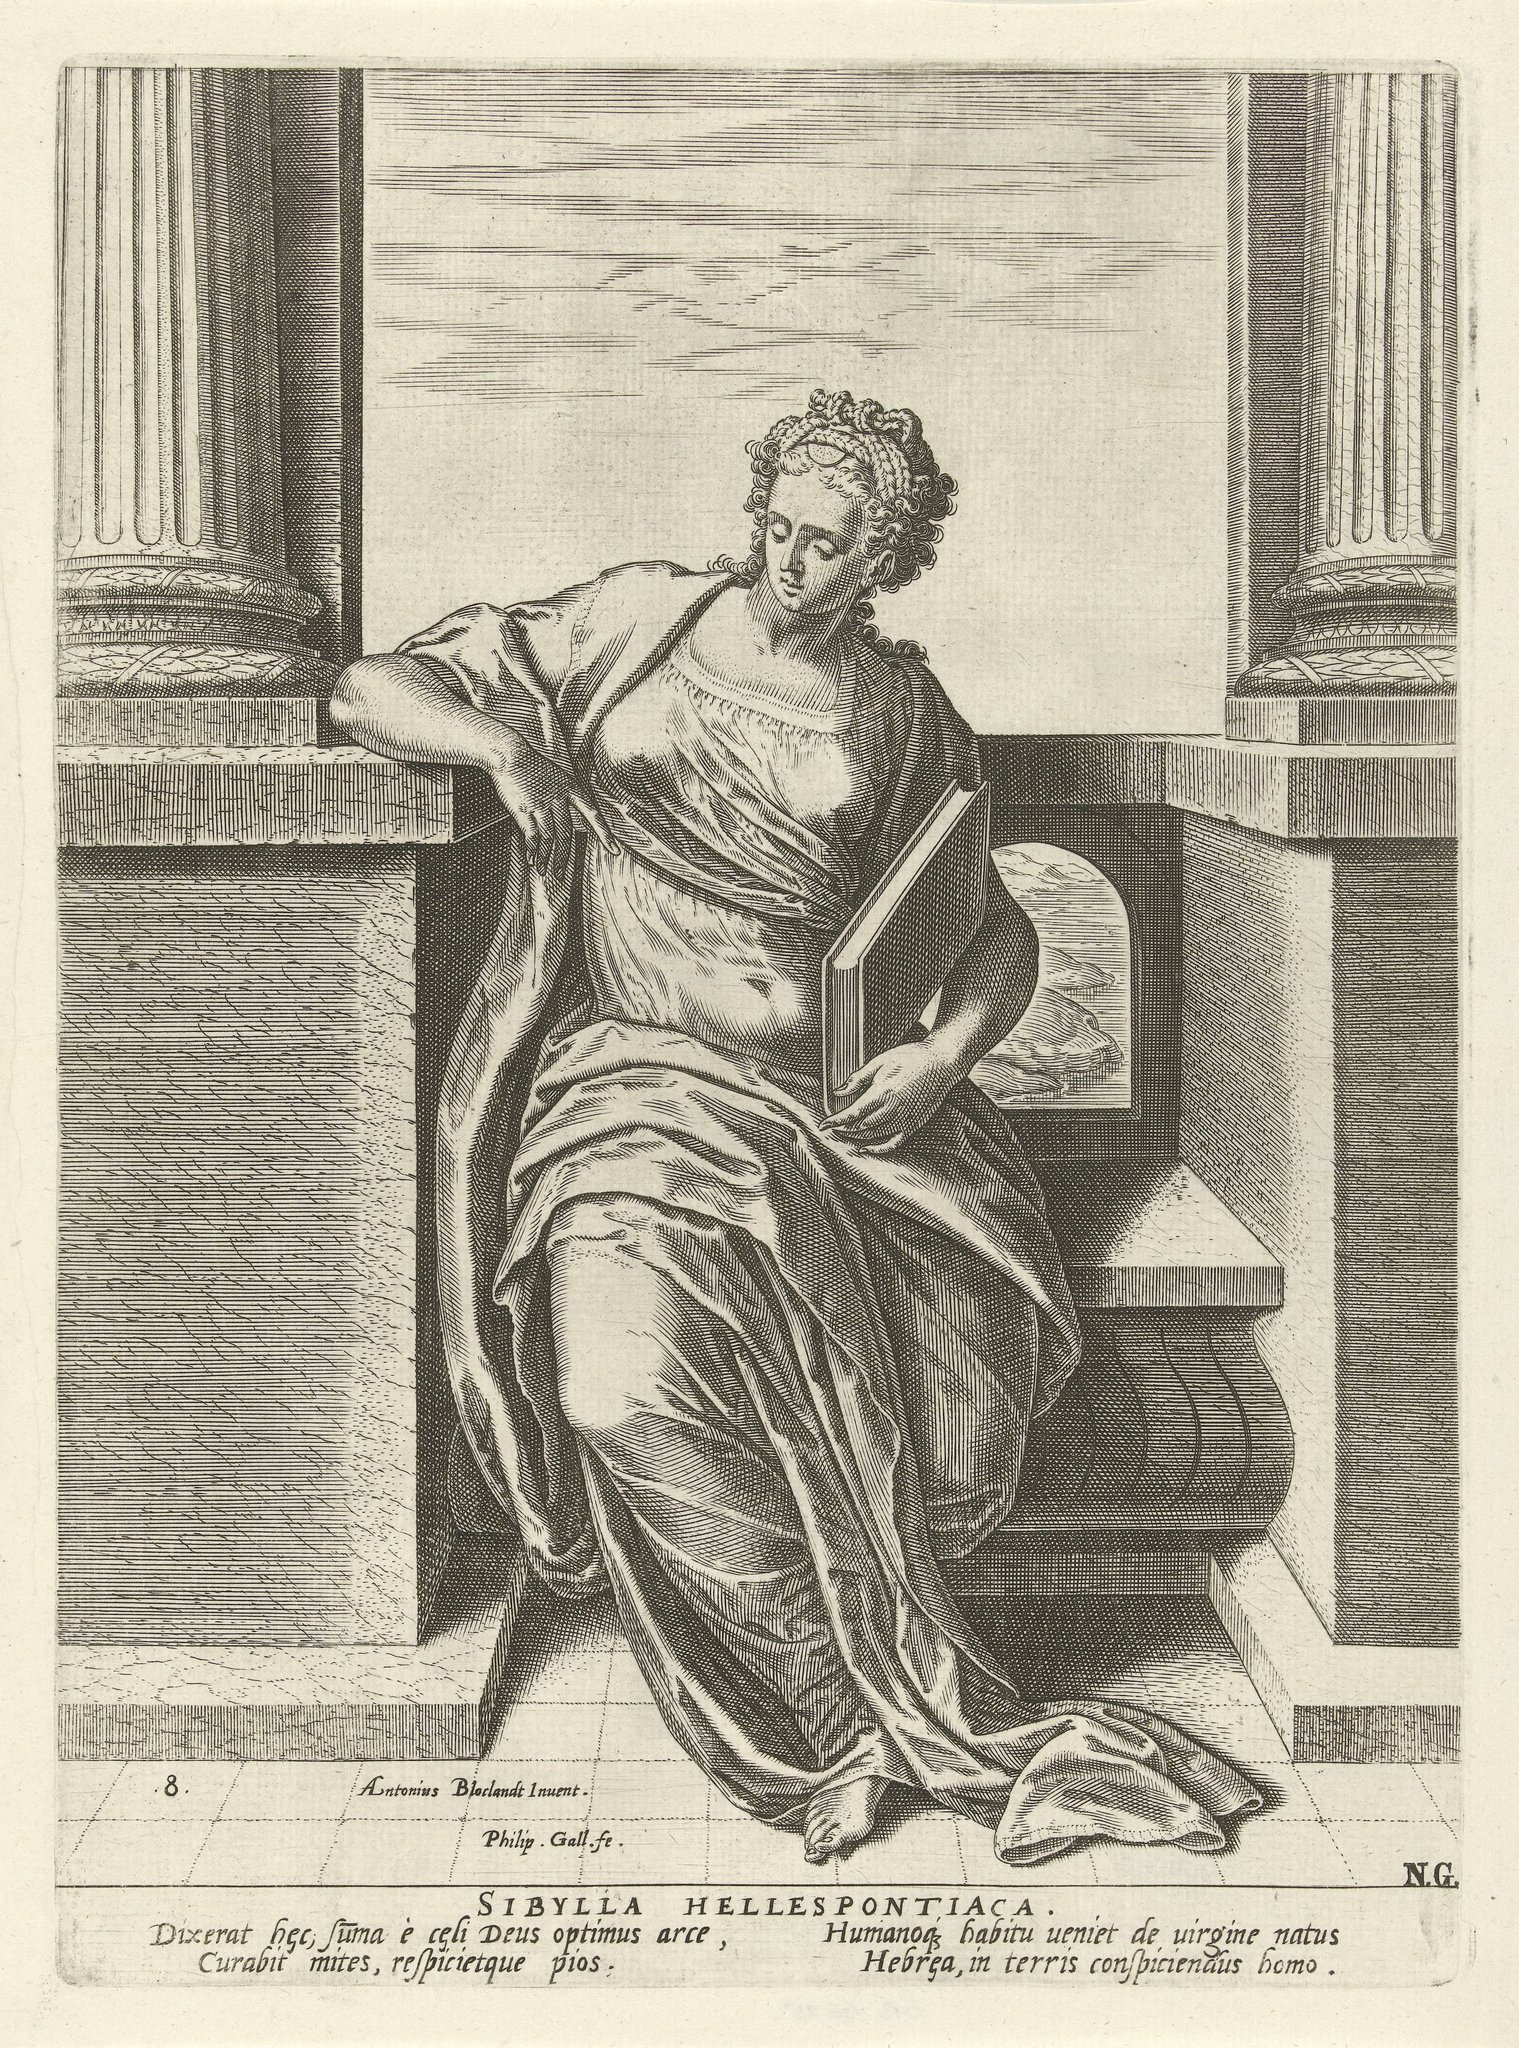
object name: print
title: Hellespontische Sibille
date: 1575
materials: paper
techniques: engraving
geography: antwerp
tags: sibyls (with name)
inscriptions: collector's mark: Lugt 1967, collector's mark: Lugt 2228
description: De Hellespontische Sibille zit op een stenen bankje. Ze heeft een boek vast. De prent heeft een Latijns onderschrift en maakt deel uit van een tiendelige serie over de Sibillen.